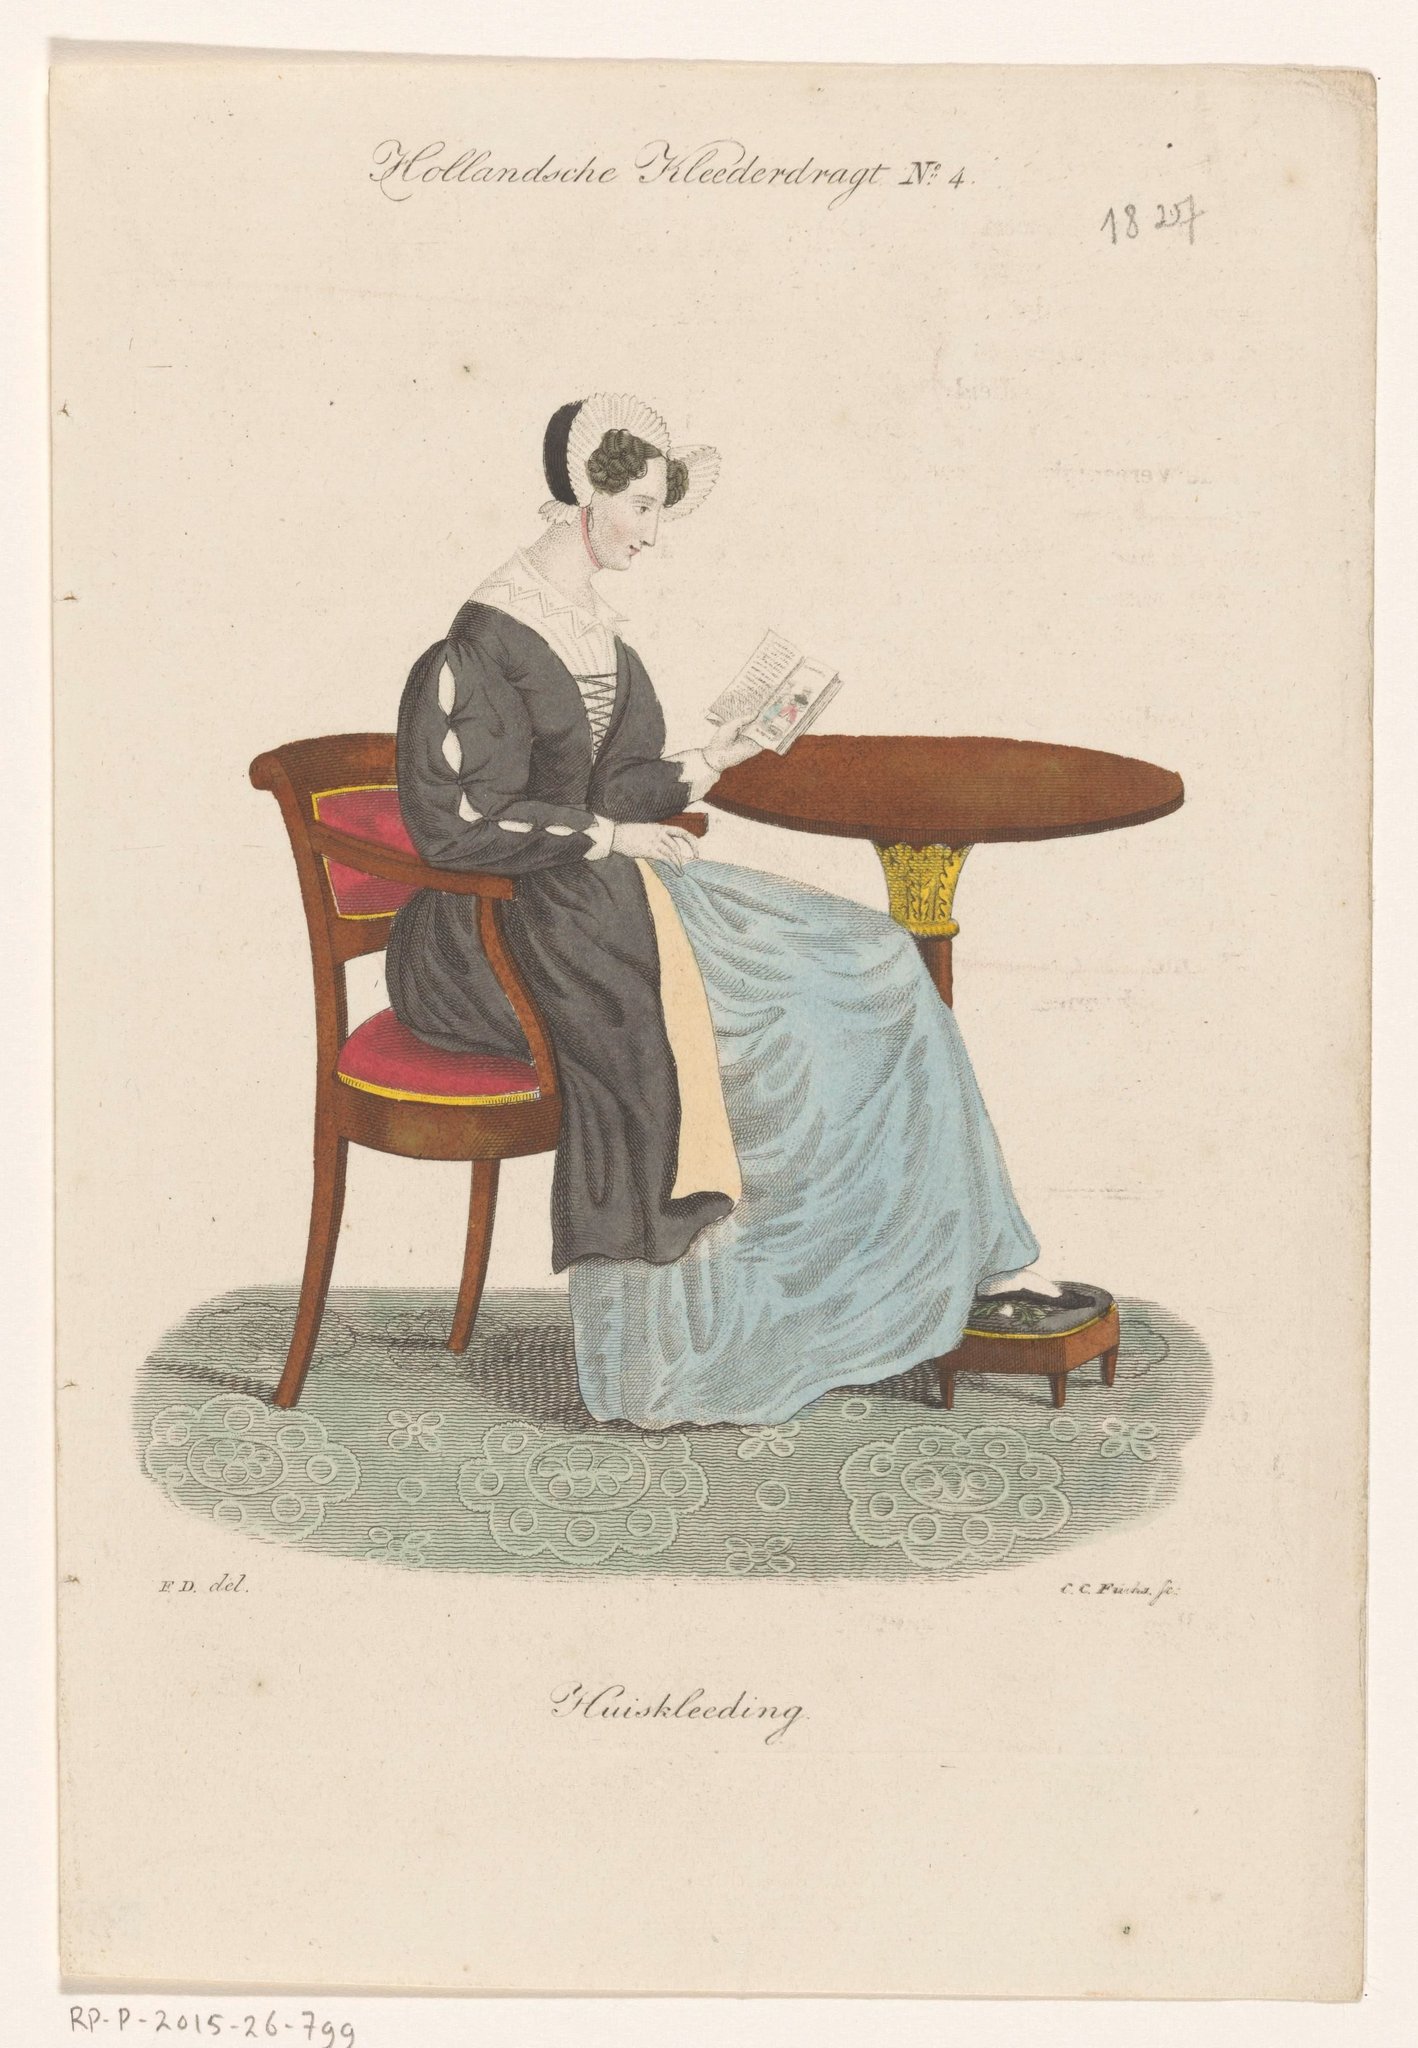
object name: fashion print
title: Huiskleeding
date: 1832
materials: paper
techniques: etching, hand coloring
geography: amsterdam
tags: fashion plates, newspaper, news-sheet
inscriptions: collector's mark: Lugt 4779, annotation: ‘1827’, collector's mark: Lugt 4780, collector's mark: Lugt 2228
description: Prent waarschijnlijk afkomstig: Euphrosyne, Tijdschrift voor de Hollandsche Kleeding, 1827.